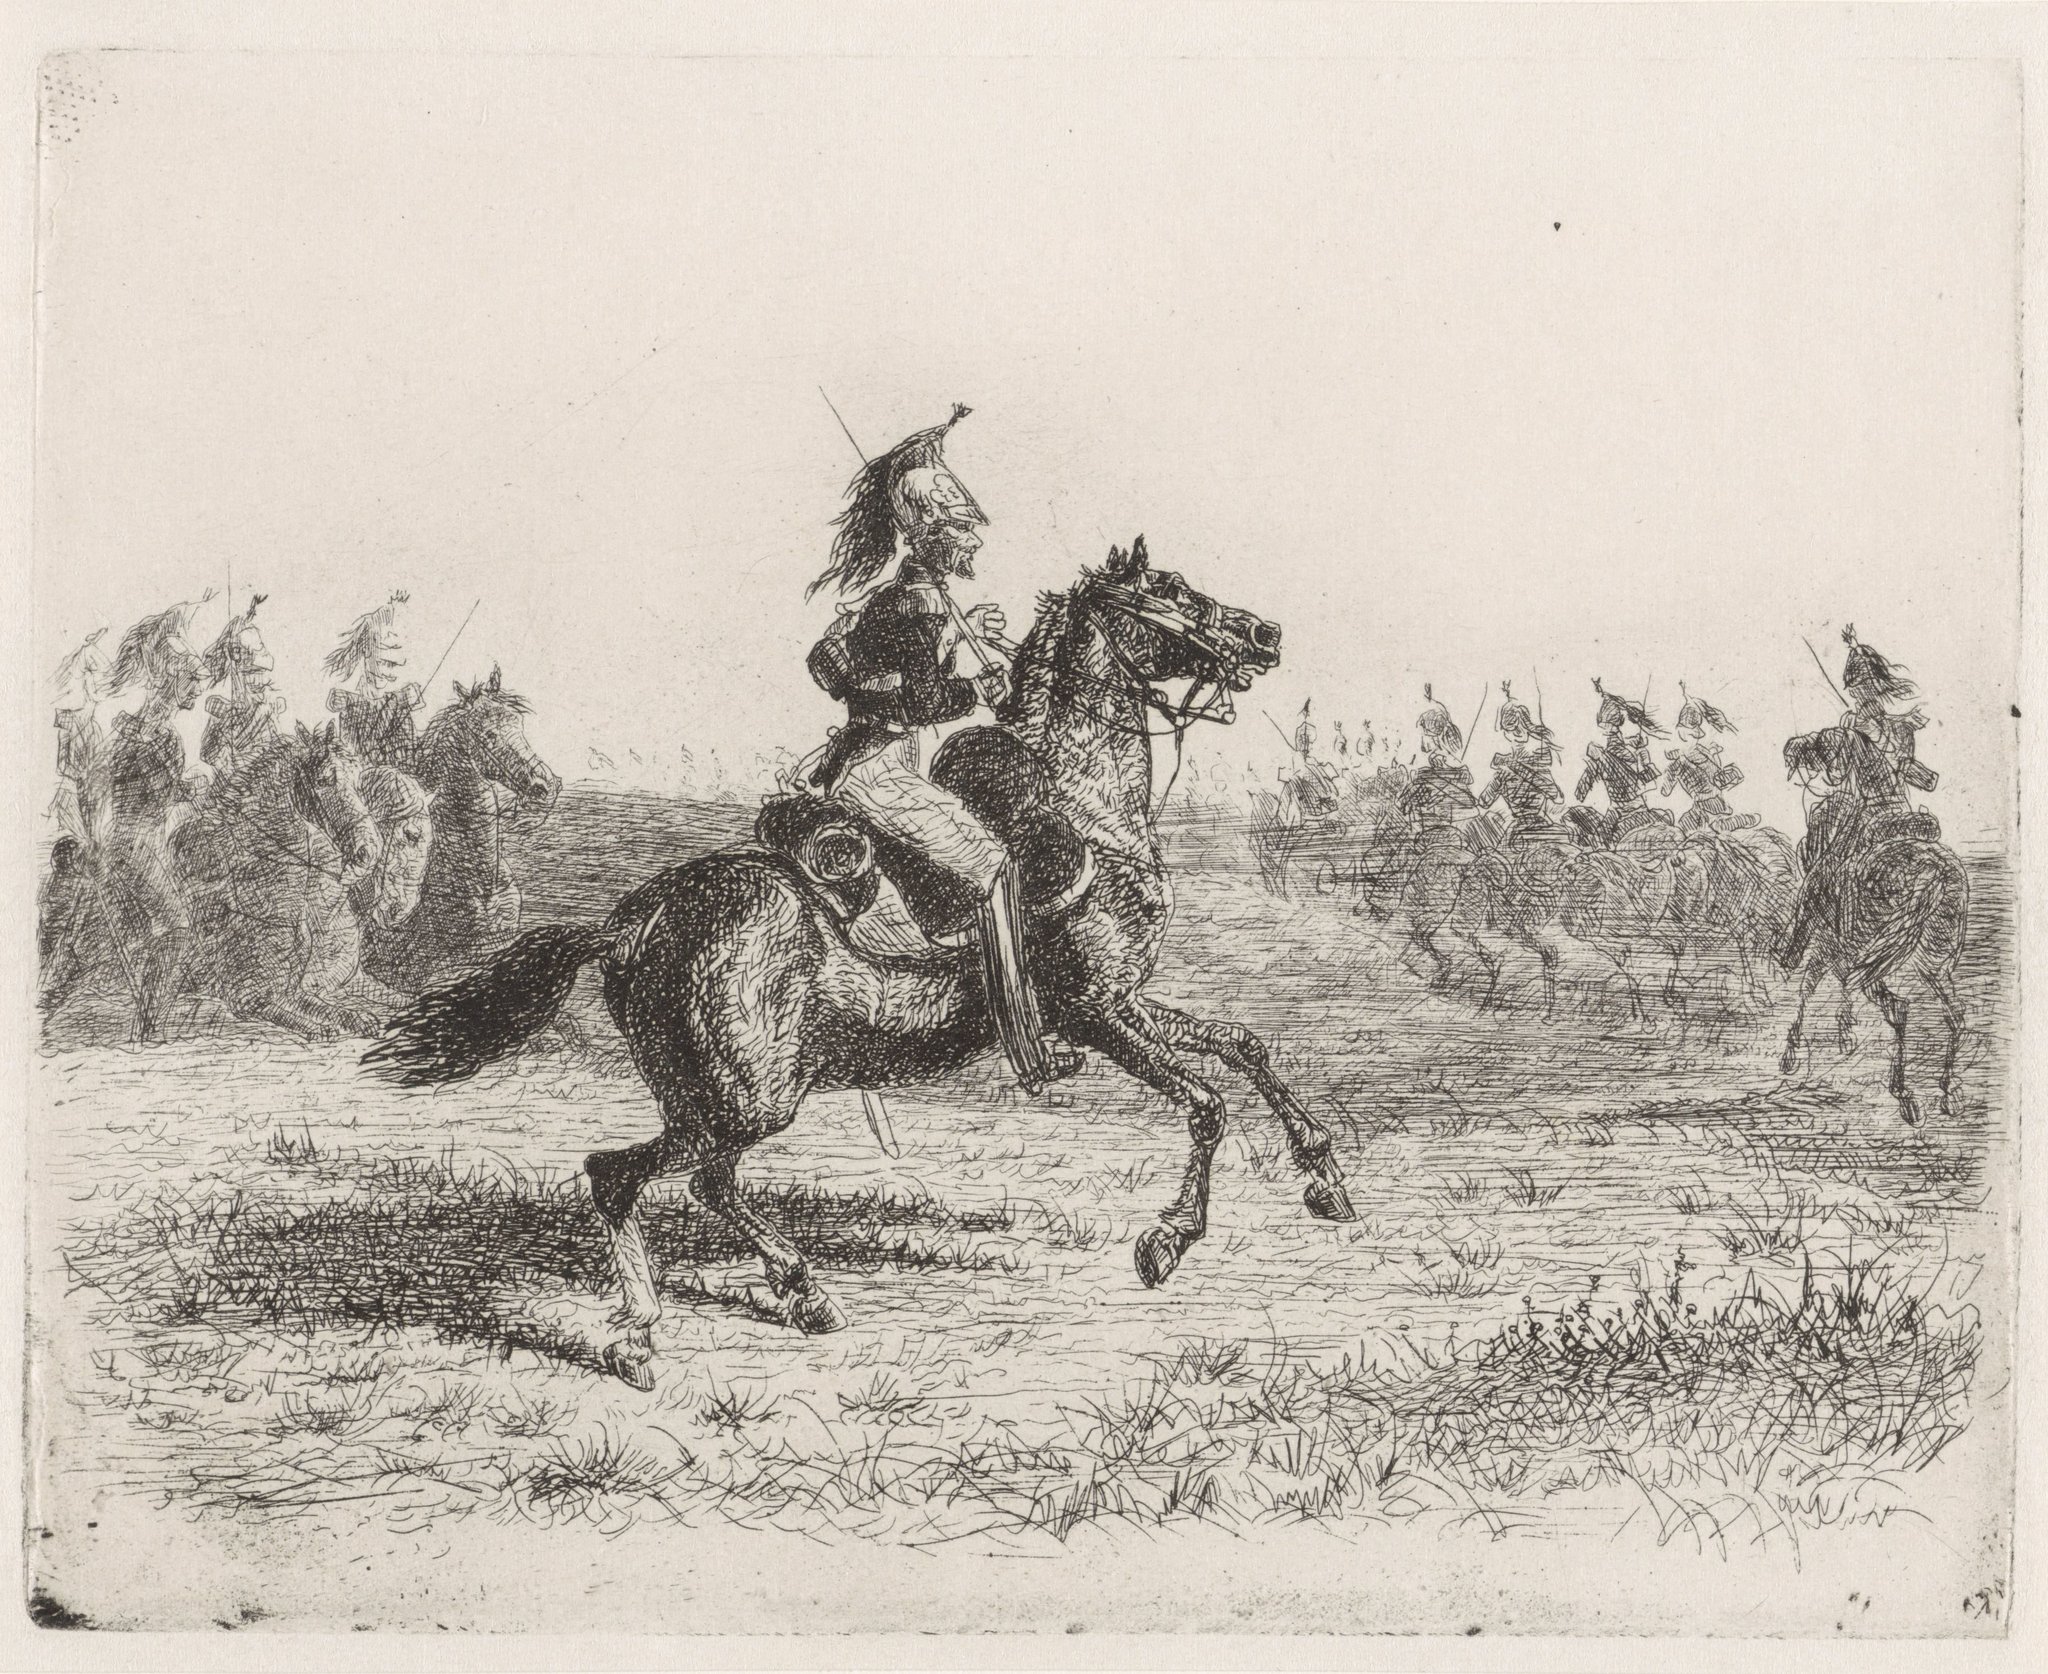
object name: print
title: Landschap met cavaleristen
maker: cornelis albertus johannes schermer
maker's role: draughtsman, painter, print maker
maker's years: 1824-1915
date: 1865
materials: paper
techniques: etching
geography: the hague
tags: the soldier; the soldier's life (+ cavalry, horsemen)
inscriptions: collector's mark: Lugt 2228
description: Vooraan een wachtmeester in wapenrusting op een paard in galop. Achter hem enkele cavaleristen, dragonders, op galopperende paarden.